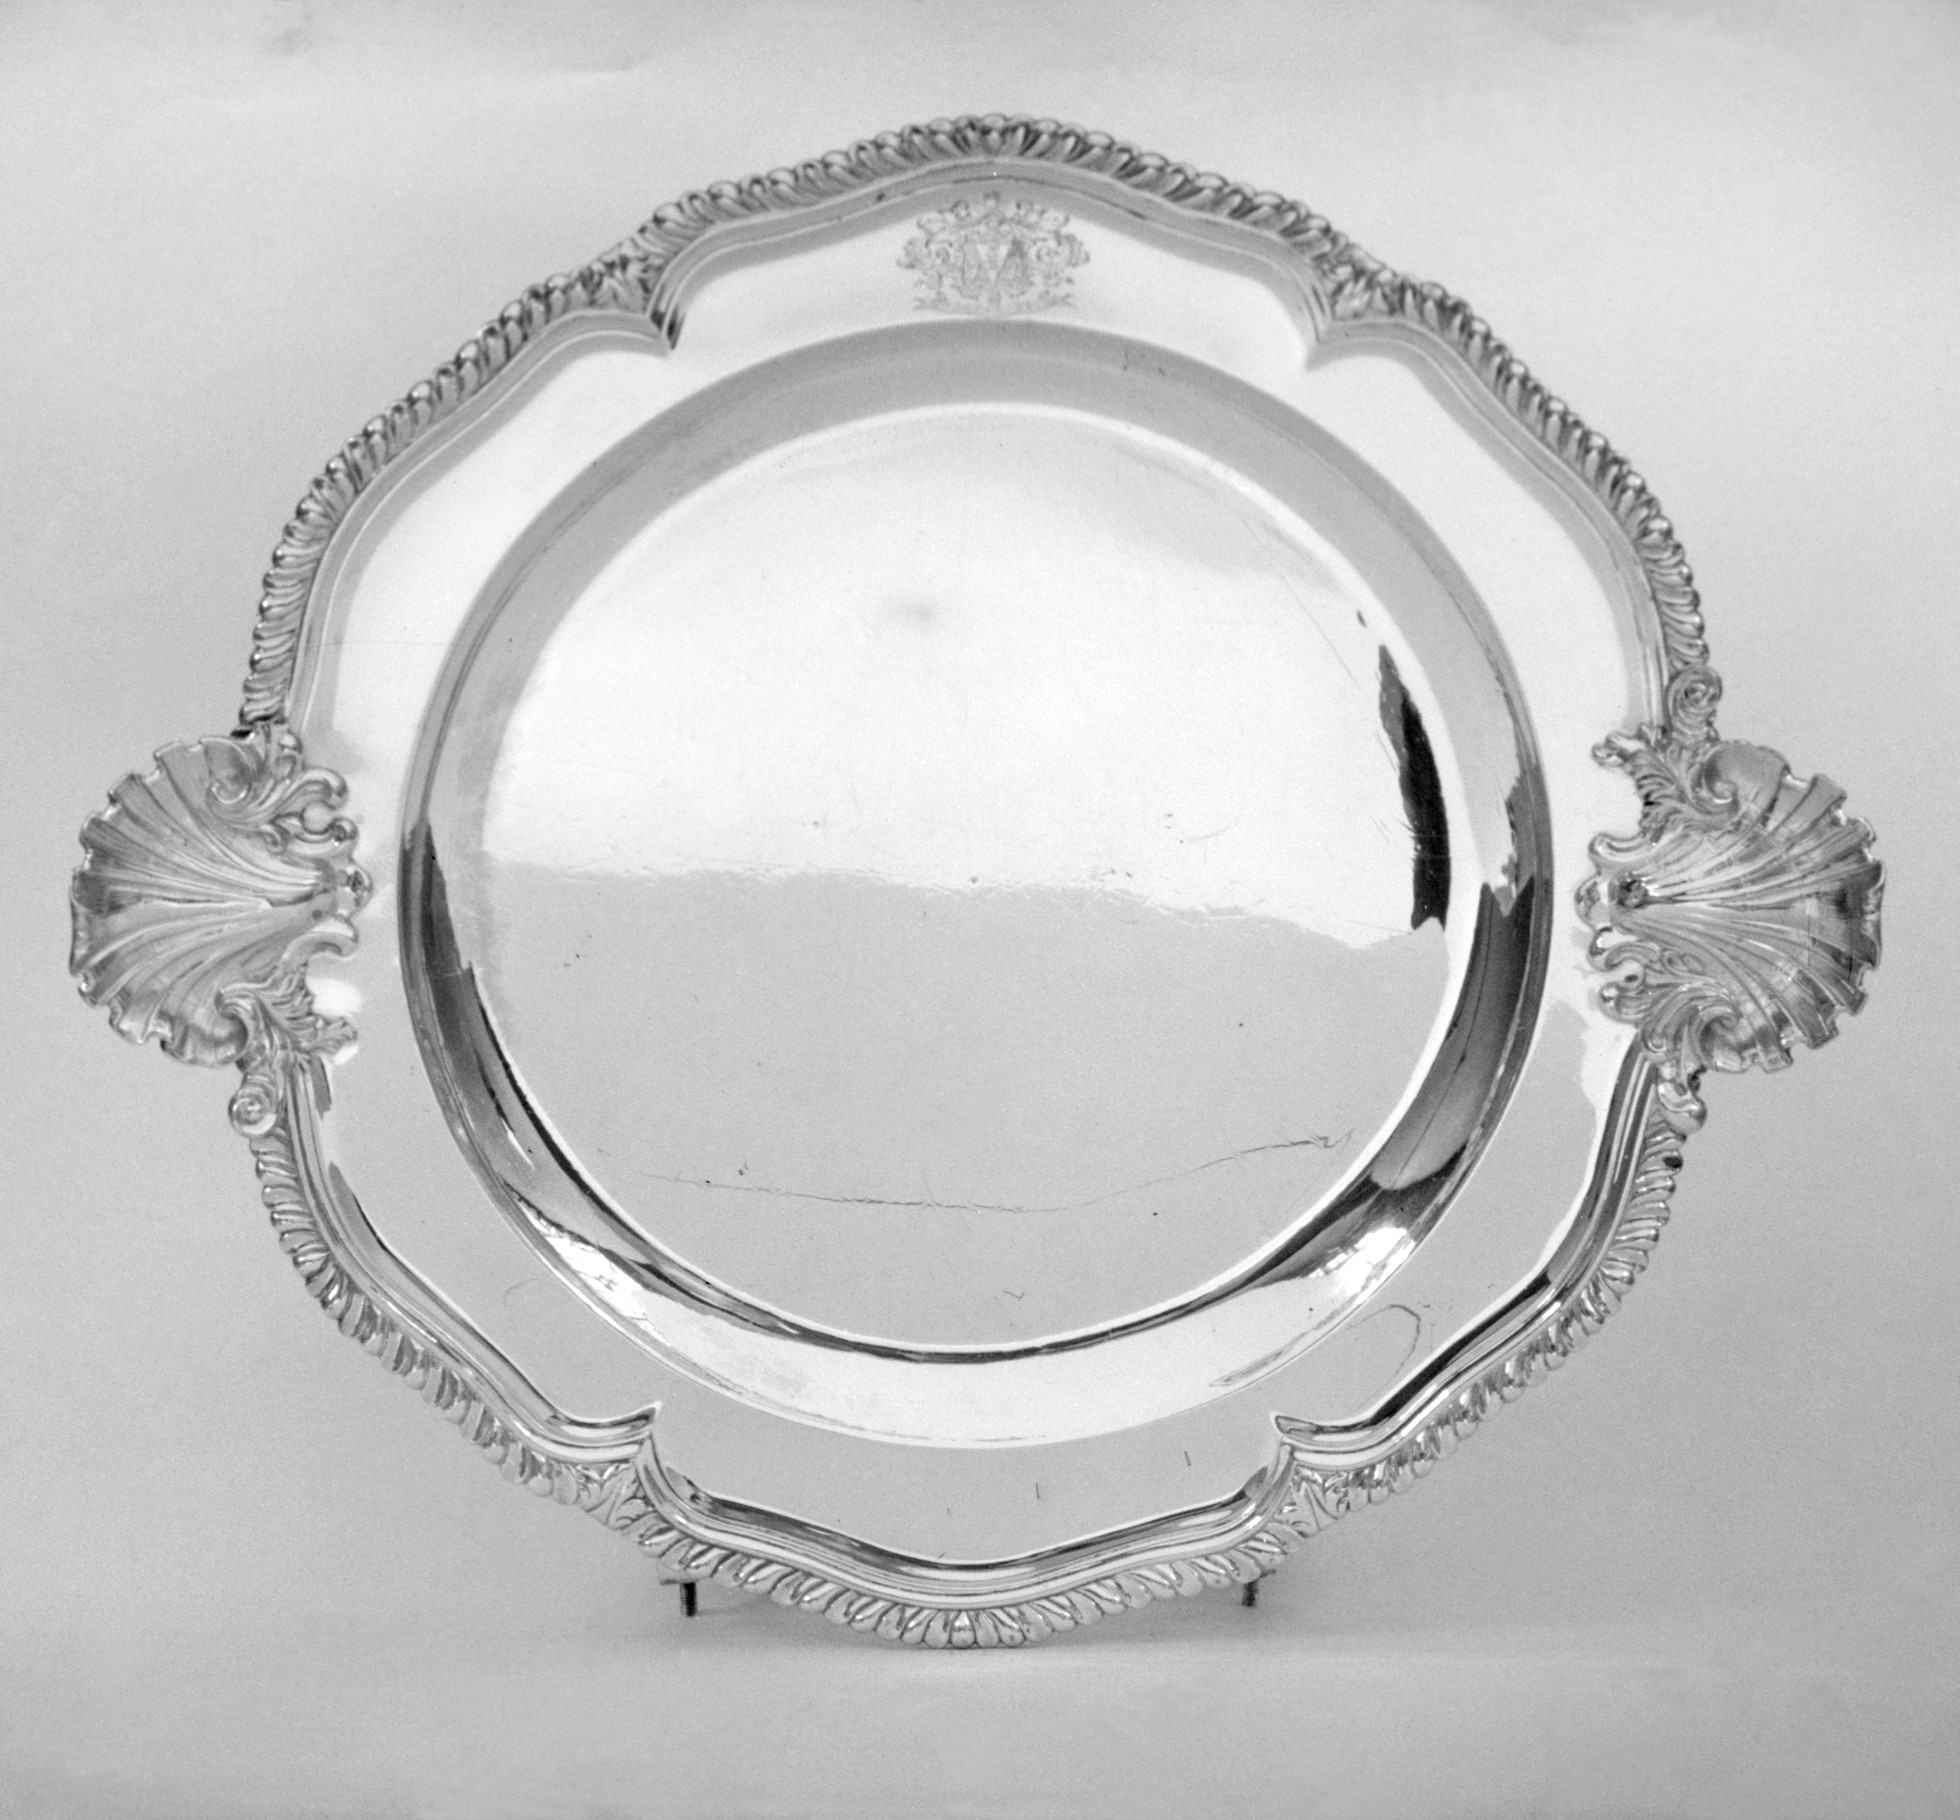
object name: dish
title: Dish (one of a graduated set of seven)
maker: paul de lamerie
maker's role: maker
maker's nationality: british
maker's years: 1688-1751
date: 1741-1742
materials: silver